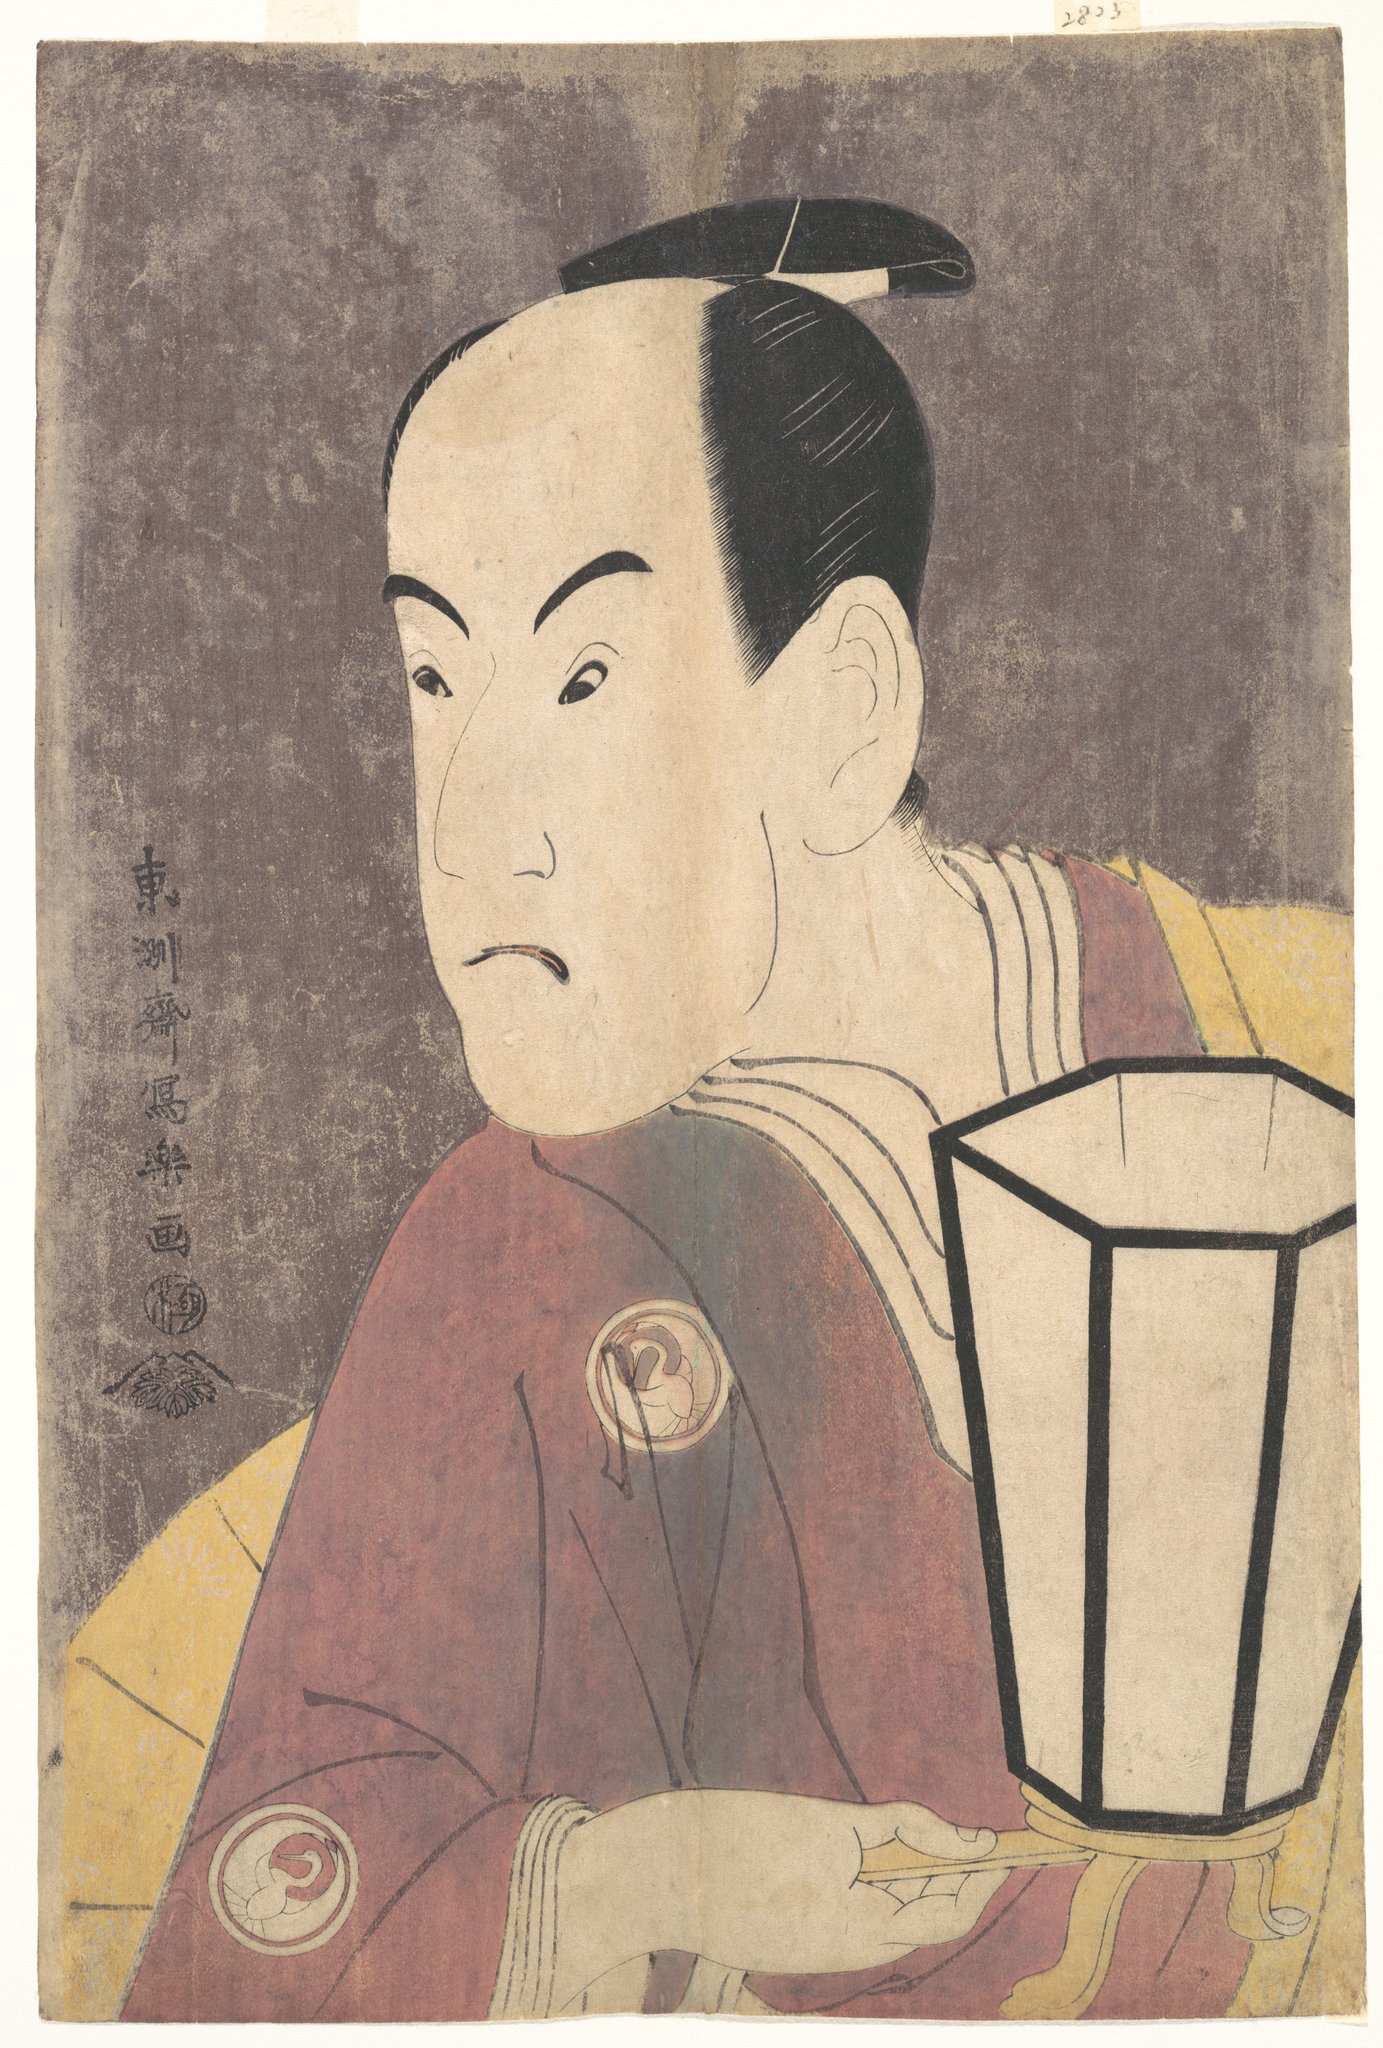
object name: print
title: Bandō Hikosaburō III as Sagisaka Sanai in the Play "Koinyōbō Somewake Tazuna"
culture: japanese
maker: tōshūsai sharaku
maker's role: artist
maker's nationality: japanese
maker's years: 1794-1795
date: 1794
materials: ink, mica, paper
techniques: woodblock print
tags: men,actors,lanterns